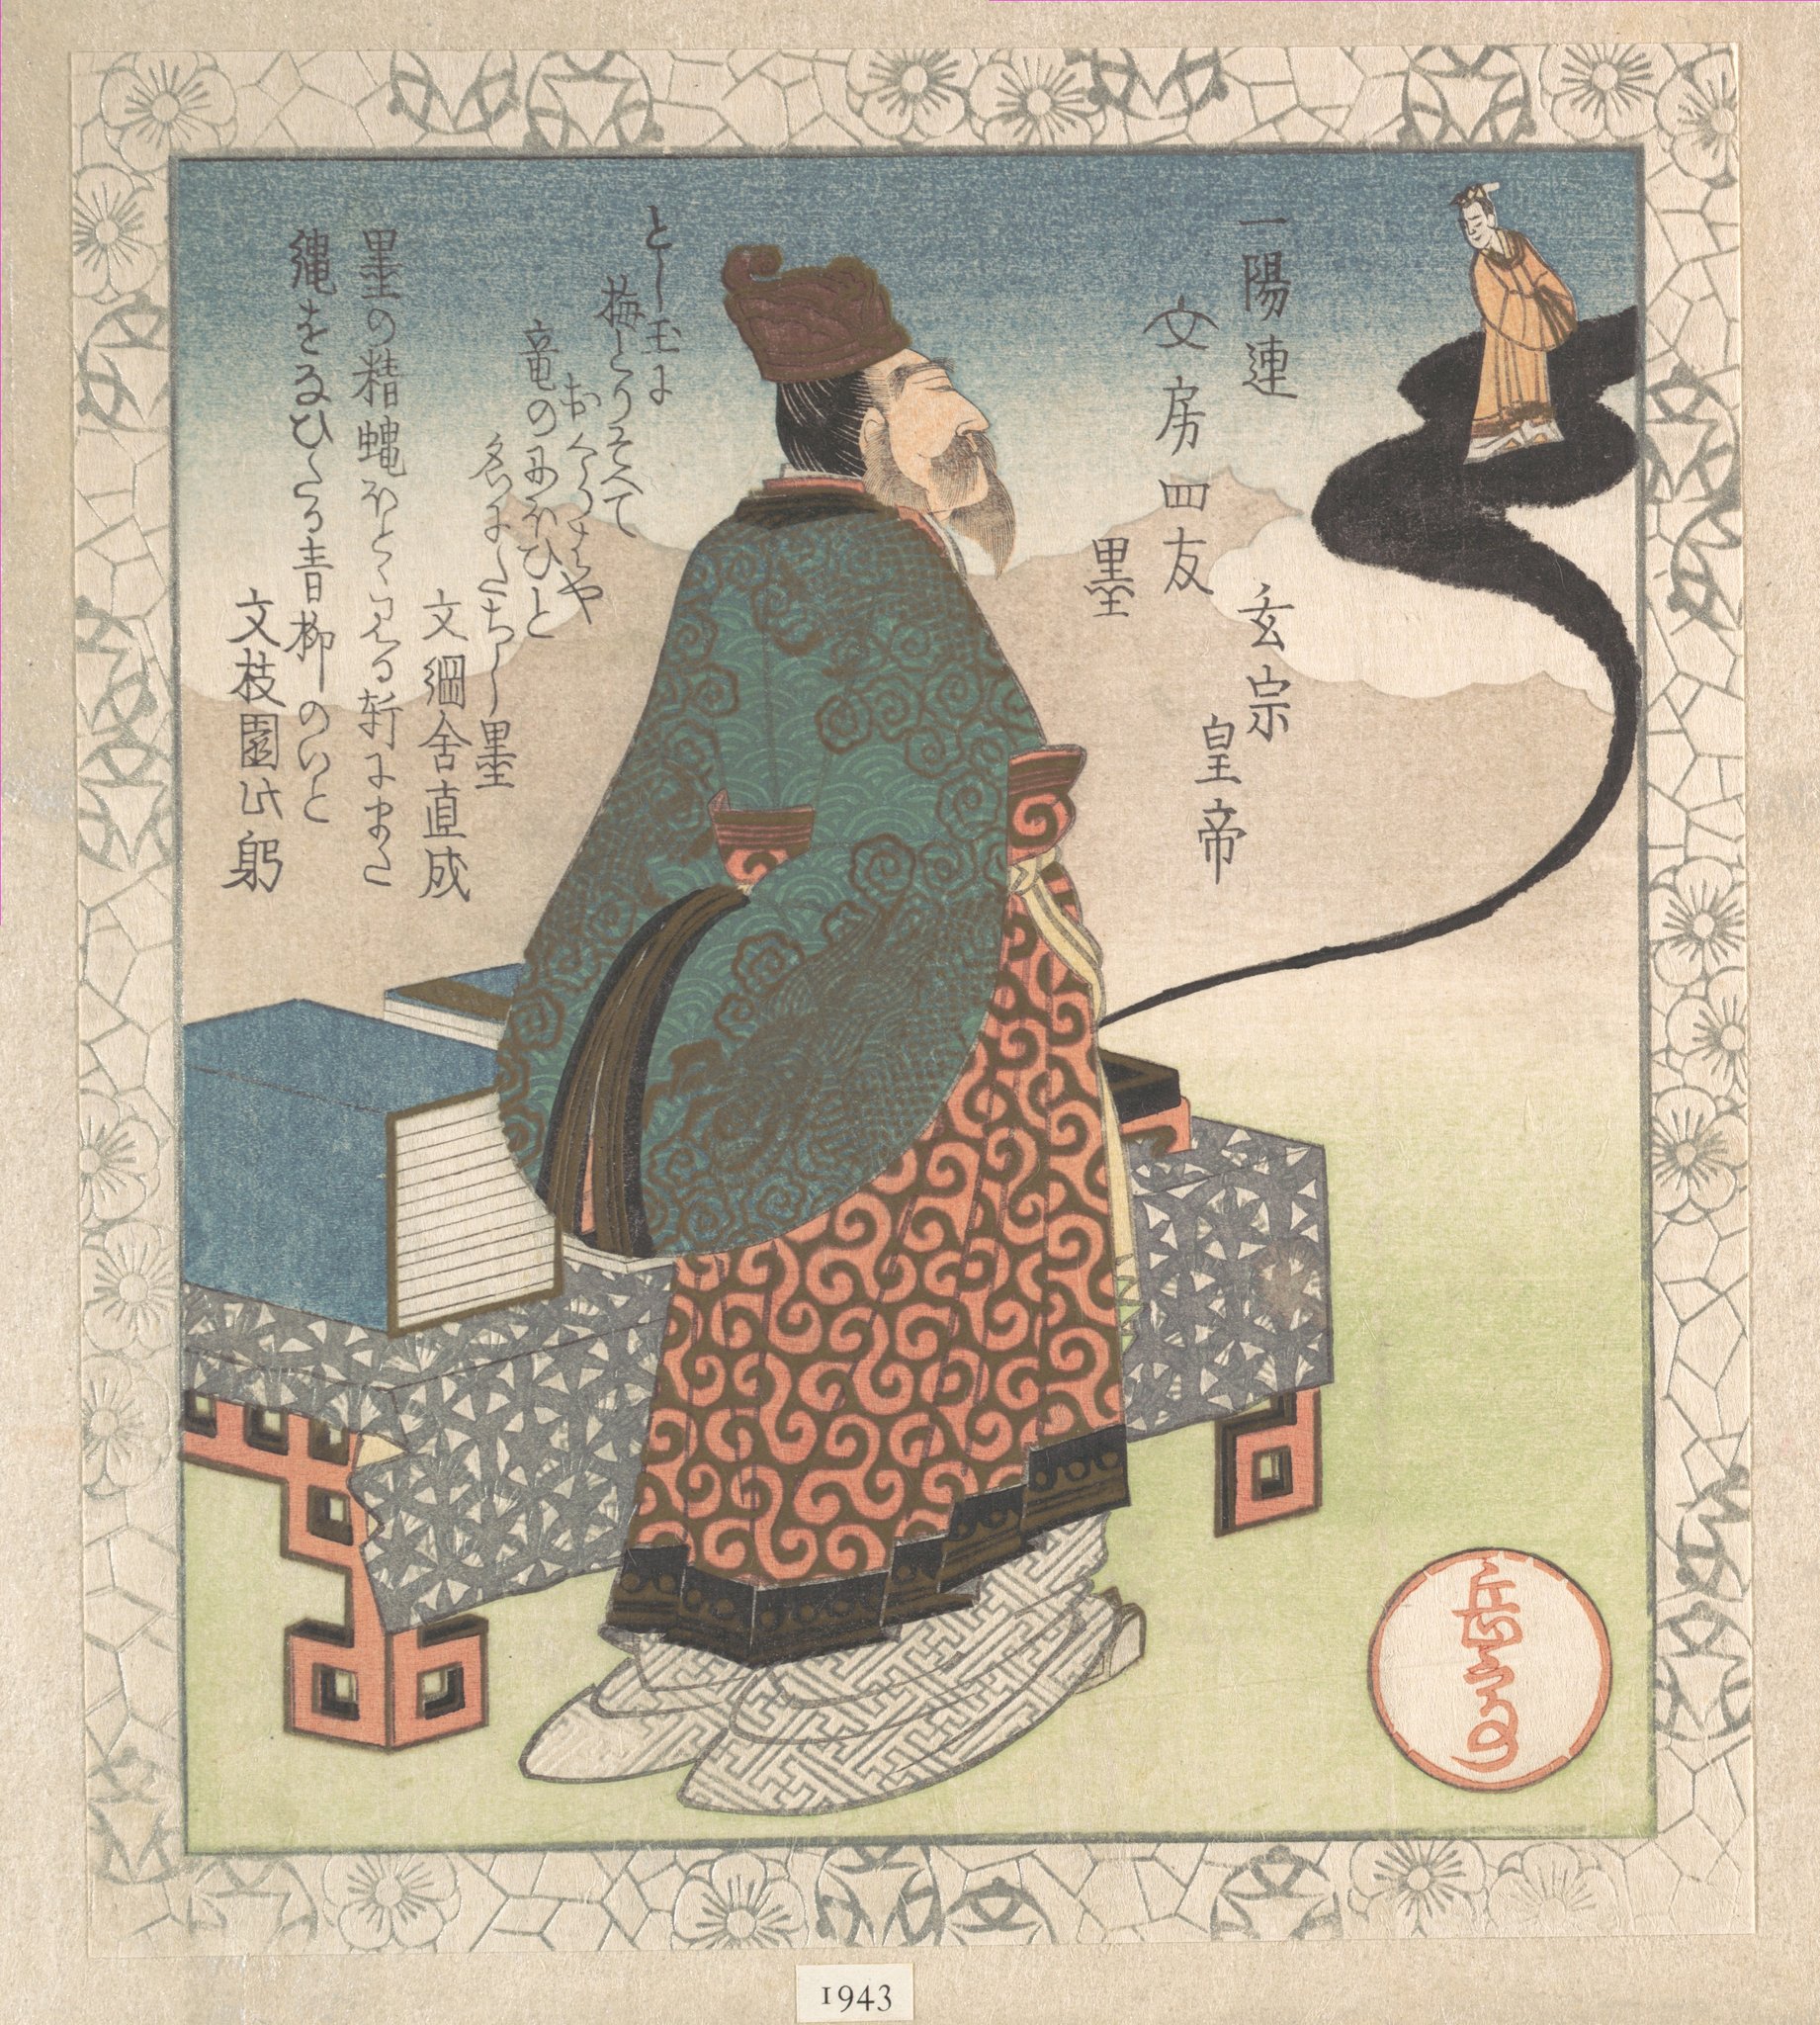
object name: print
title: Emperor Xuanzong (Japanese: Gensō) and Daoist Magician Lo Gongyuan Arising from an Inkstone; “Ink” (Sumi), from Four Friends of the Writing Table for the Ichiyō Poetry Circle (Ichiyō-ren Bunbō shiyū) From the Spring Rain Collection (Harusame shū), vol. 1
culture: japanese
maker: yashima gakutei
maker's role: artist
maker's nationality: japanese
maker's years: 1786-1868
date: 1827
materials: ink, paper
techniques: surimono, woodblock print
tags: poetry,men